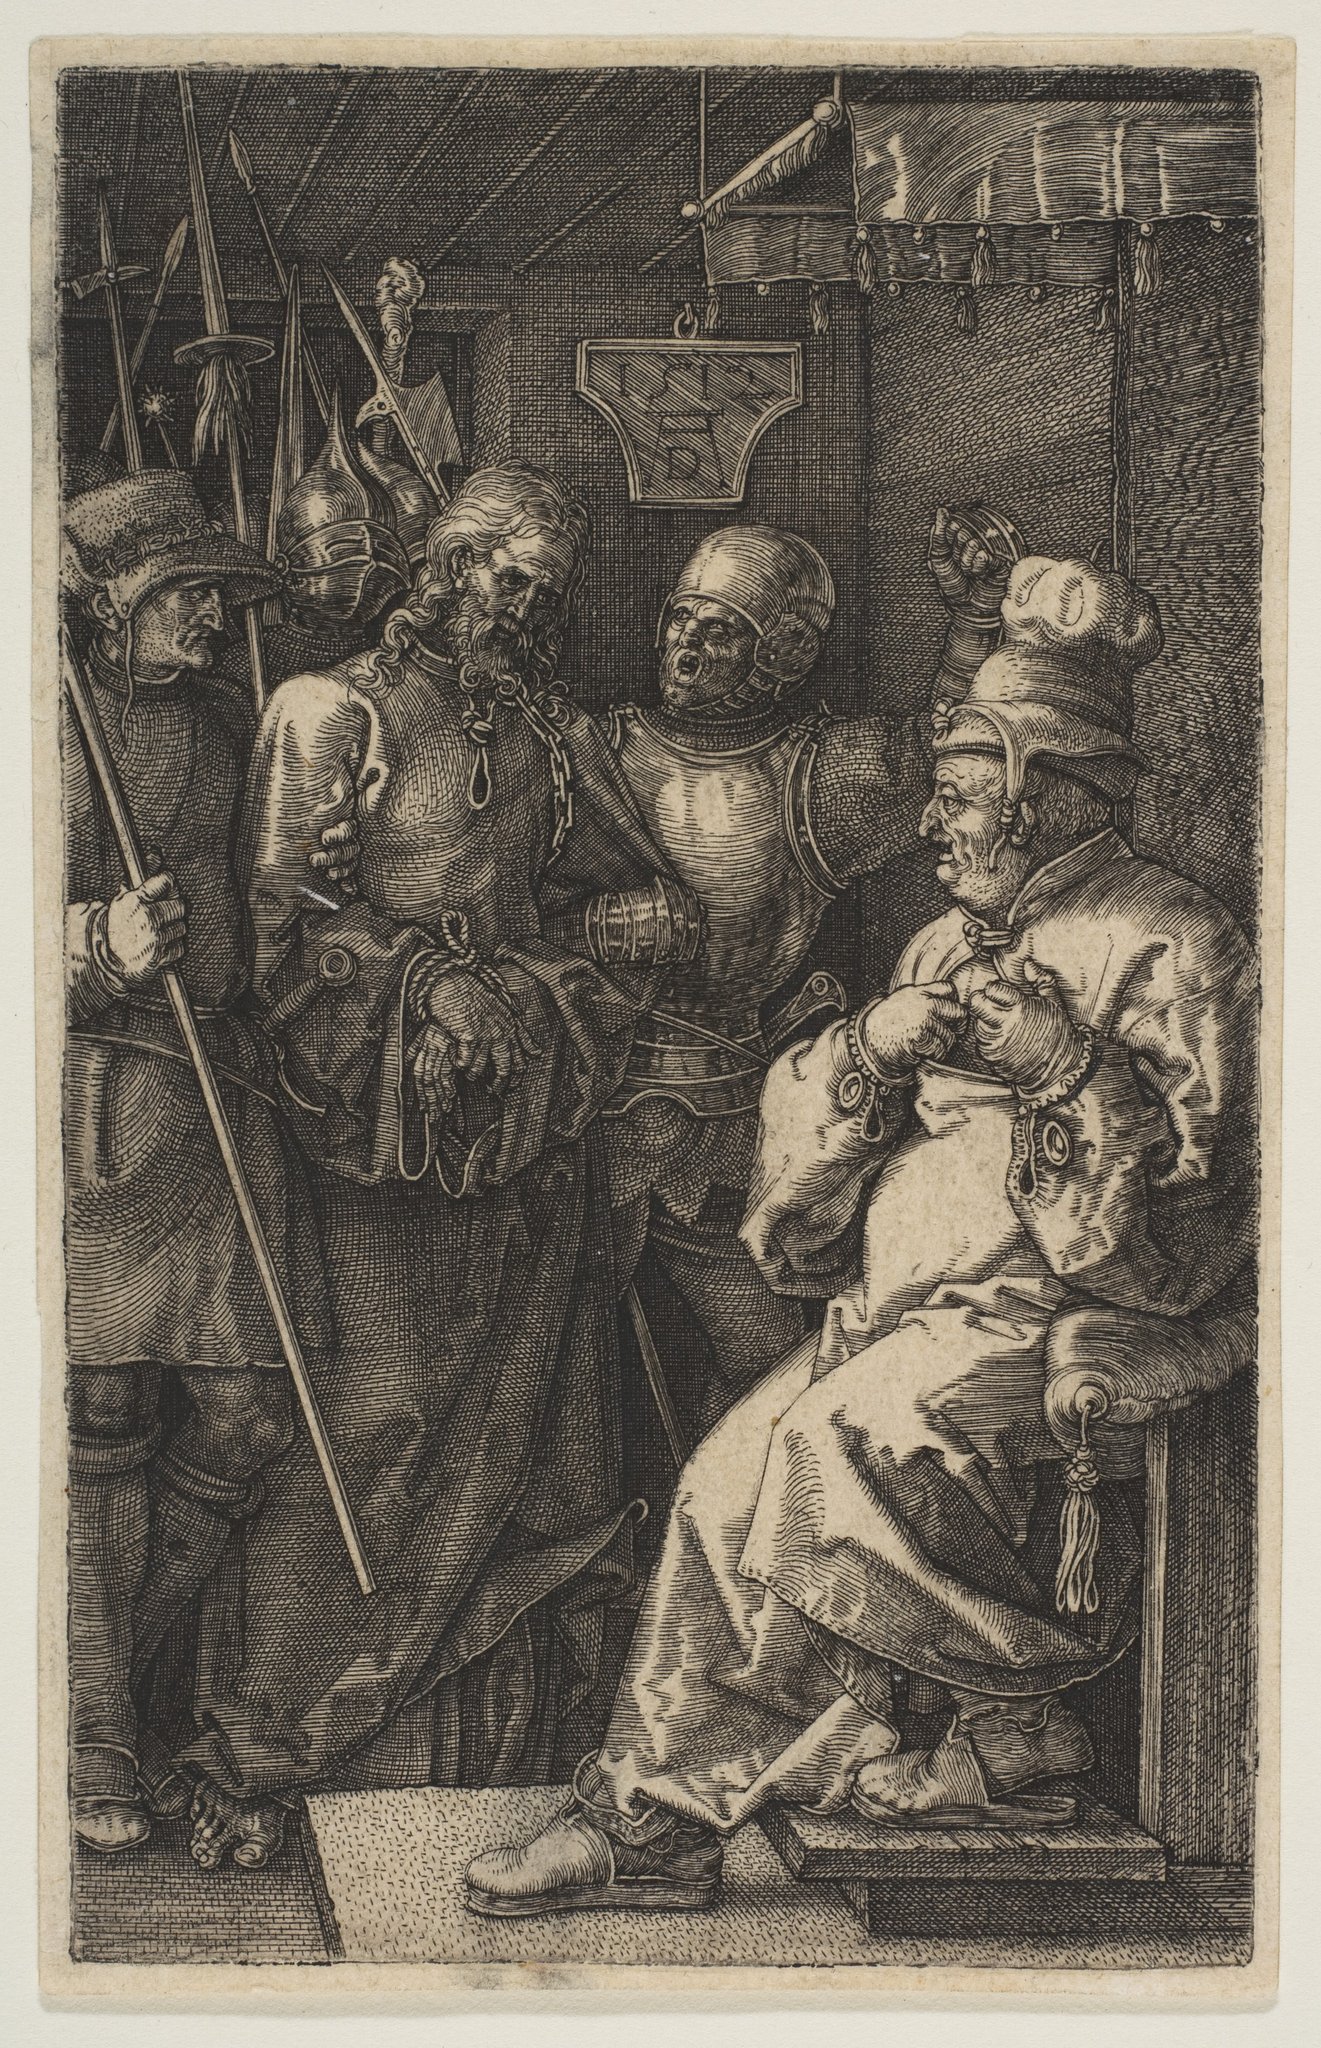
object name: print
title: Christ before Caiaphas, from "The Passion"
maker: albrecht dürer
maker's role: artist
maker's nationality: german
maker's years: 1471-1528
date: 1512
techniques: engraving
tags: soldiers,men,christ